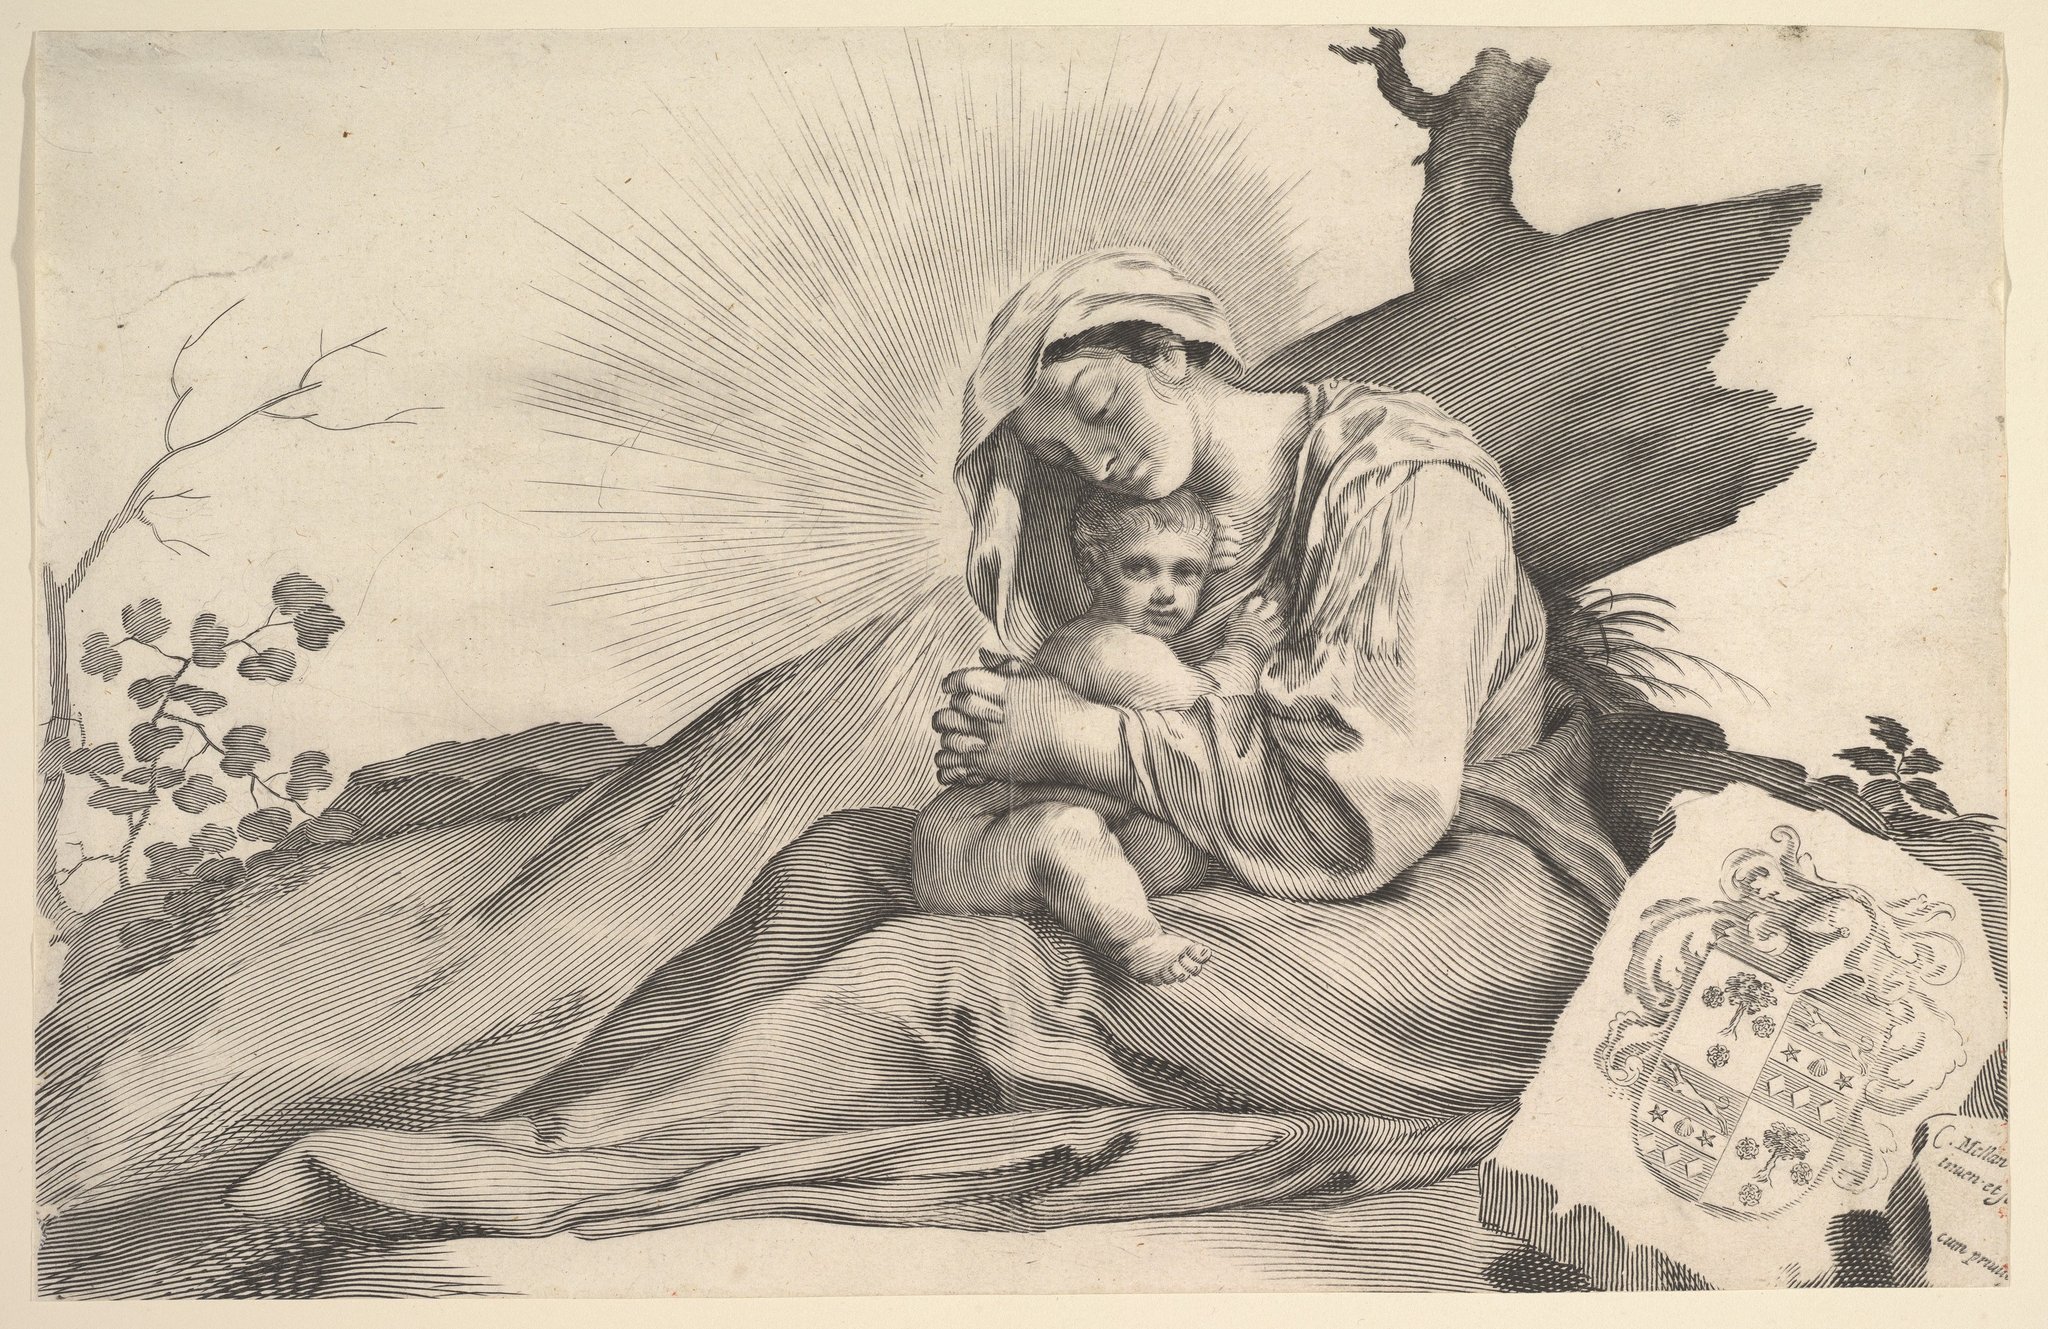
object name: print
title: Virgin and Child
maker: claude mellan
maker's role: artist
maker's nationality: french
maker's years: 1598-1688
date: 1600-1688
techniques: engraving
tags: madonna and child,coat of arms